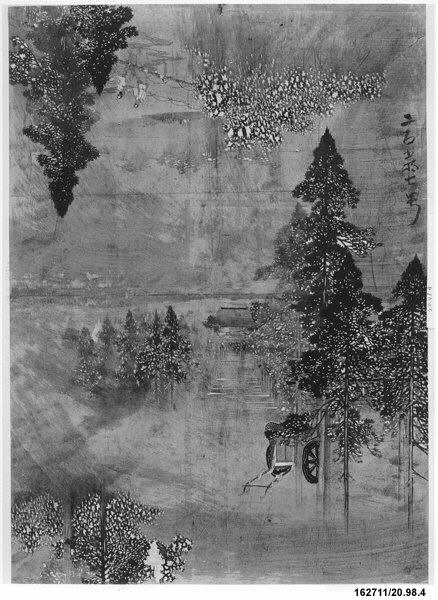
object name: textile design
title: Textile Design for Stencil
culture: japanese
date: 1601-1700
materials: paint, paper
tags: trees